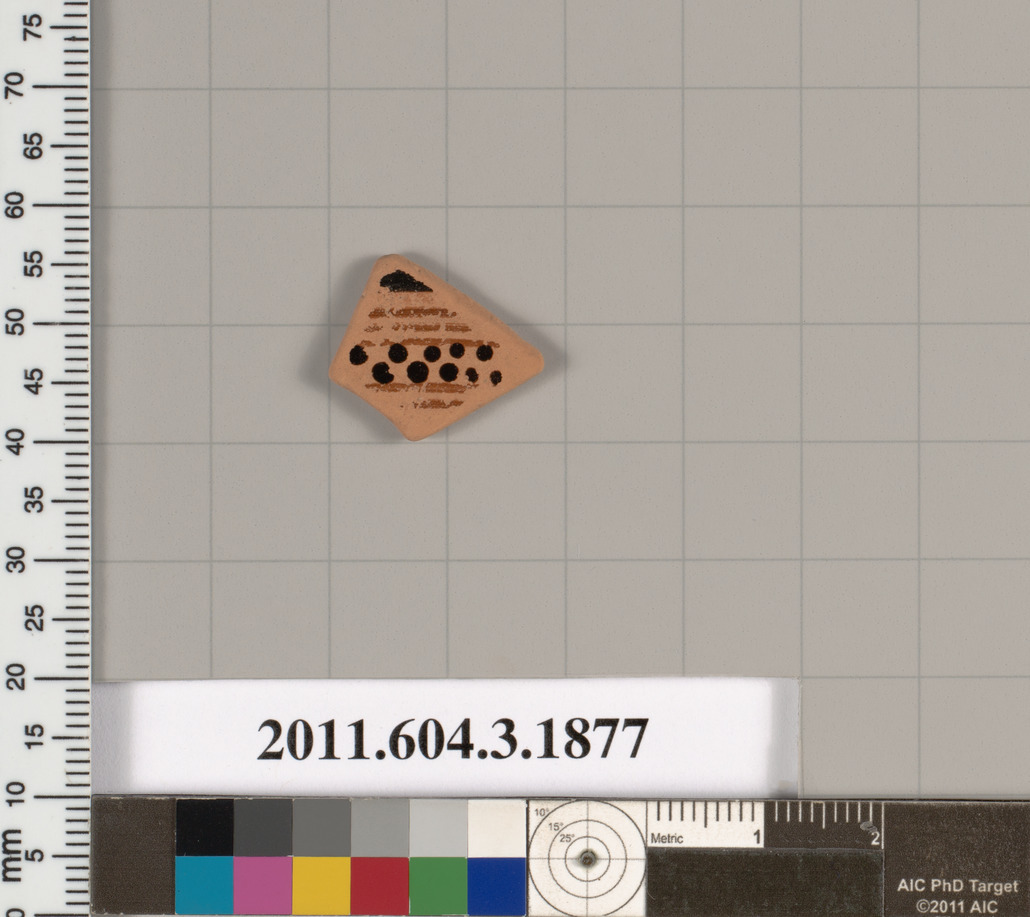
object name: kylix fragment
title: Terracotta fragment of a kylix: Band or lip cup (drinking cup)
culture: greek, attic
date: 567-535 BCE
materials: terracotta